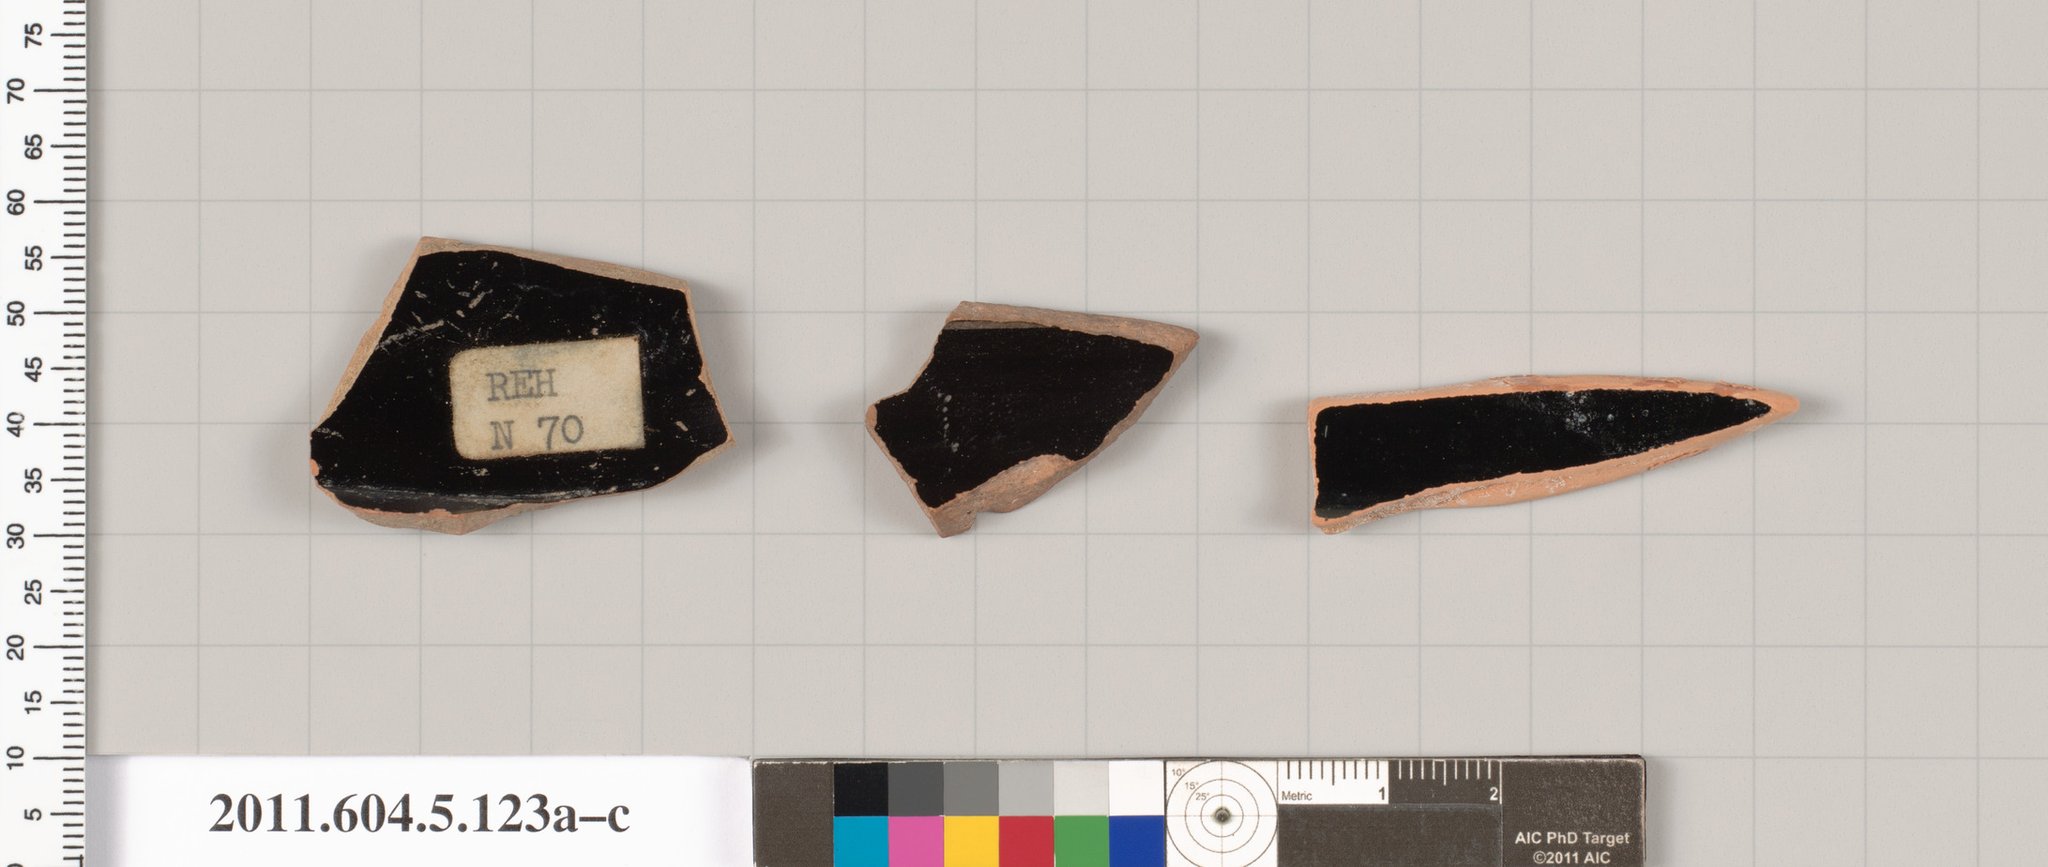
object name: kylix fragment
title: Terracotta fragments of stemless kylikes (drinking cups)?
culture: greek, attic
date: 470-450 BCE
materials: terracotta